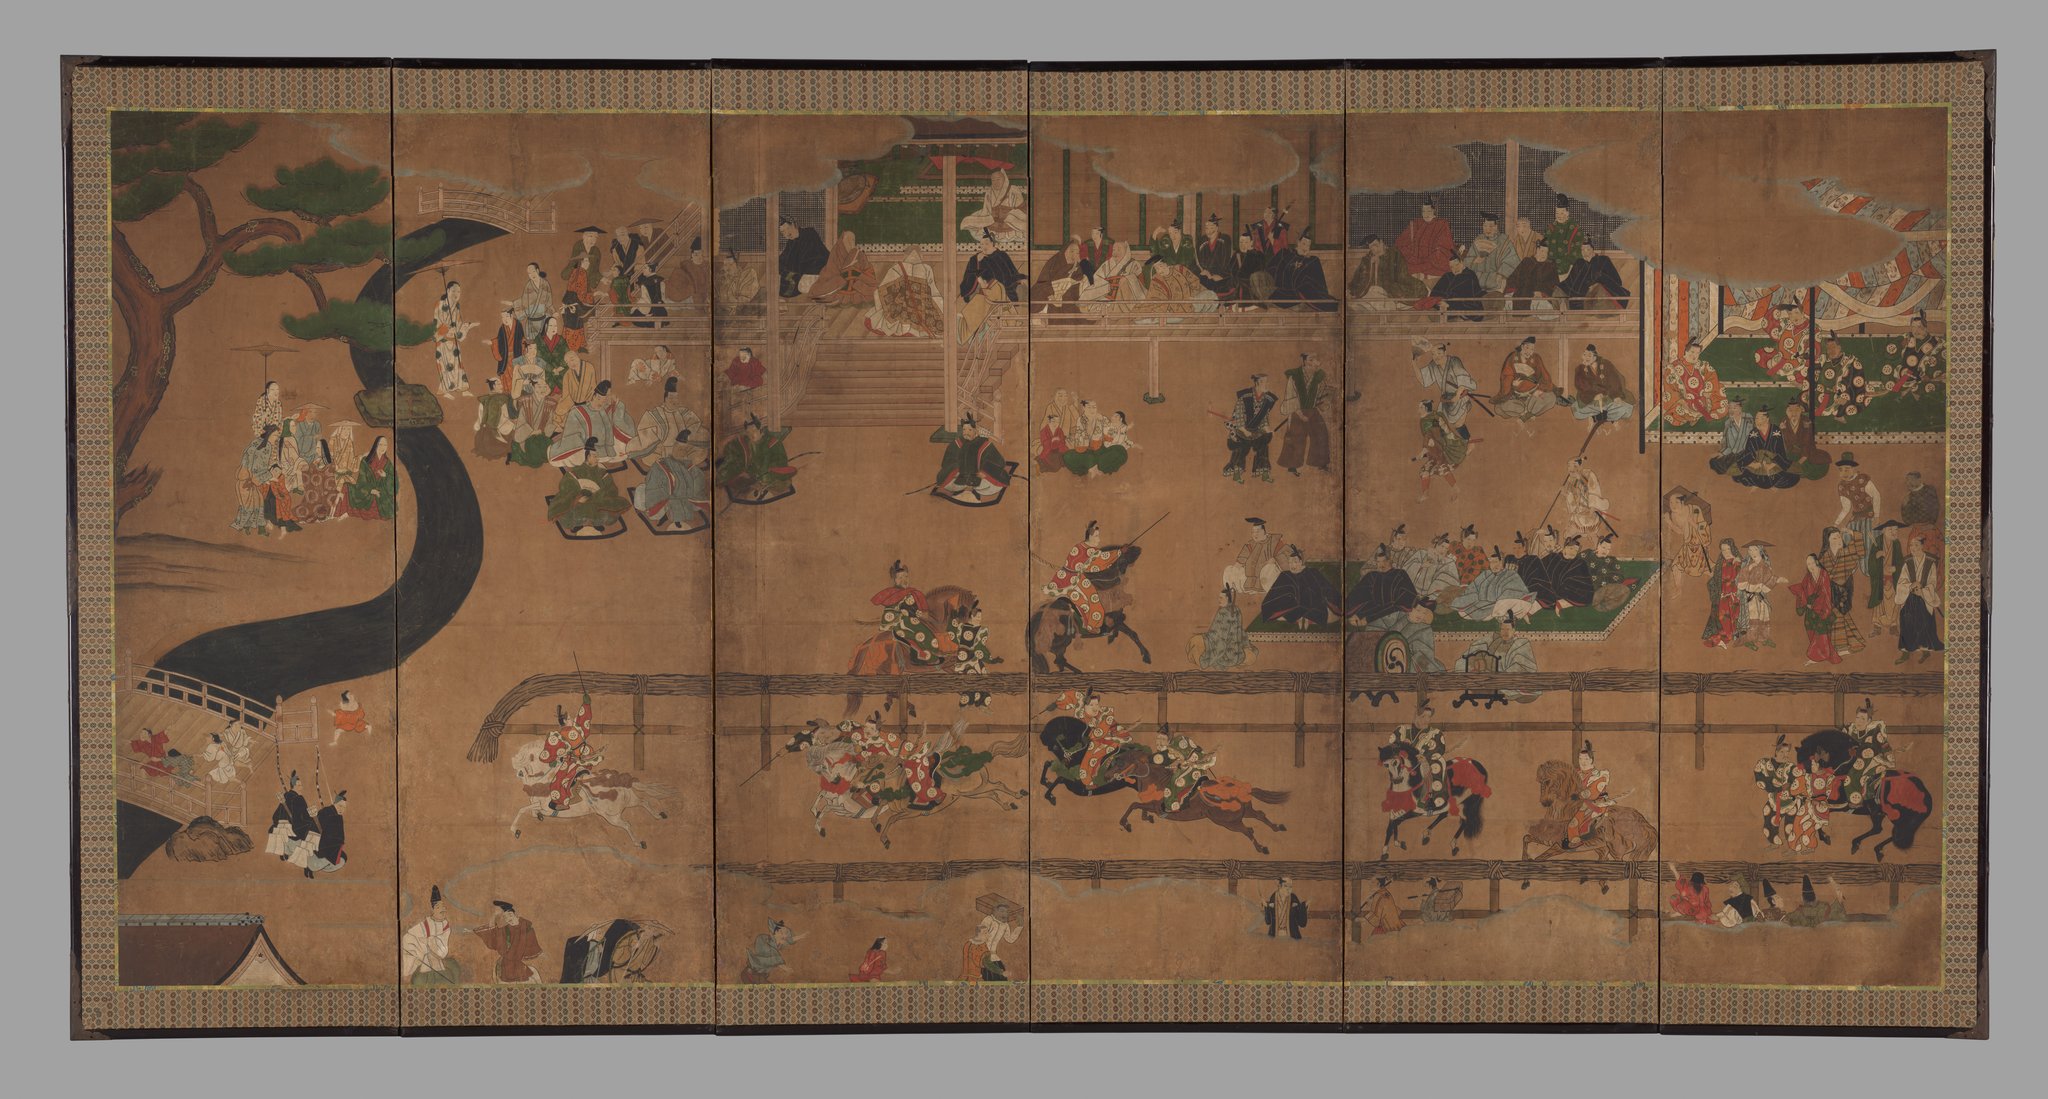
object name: screen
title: Horse Race at the Kamo Shrine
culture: japanese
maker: unidentified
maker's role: artist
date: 1600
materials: gold leaf, ink, panel, paper, silver